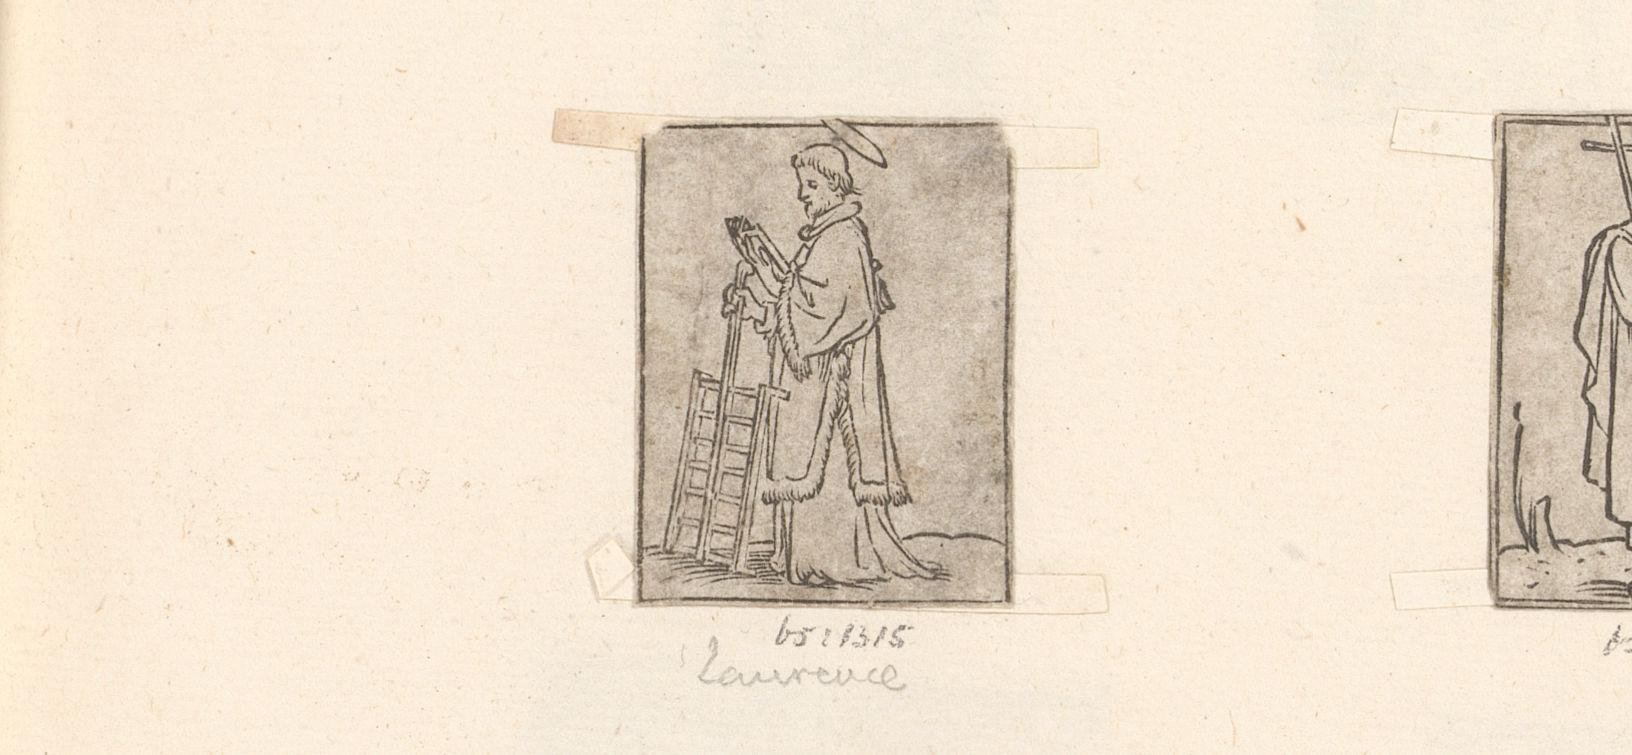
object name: album leaf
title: Apostelen, aartsengelen en heiligen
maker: hans holbein (der jüngere)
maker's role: draughtsman, painter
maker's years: 1497-1543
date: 1507-1543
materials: paper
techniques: woodcut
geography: switzerland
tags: the martyr and deacon laurence of rome; possible attributes: book, censer, cross, dalmatic, gridiron, palm, purse (or cup with golden coins)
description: De heilige Laurentius met een open boek in zijn linkerhand en het rooster in zijn rechterhand. Prent maakt deel uit van een album.